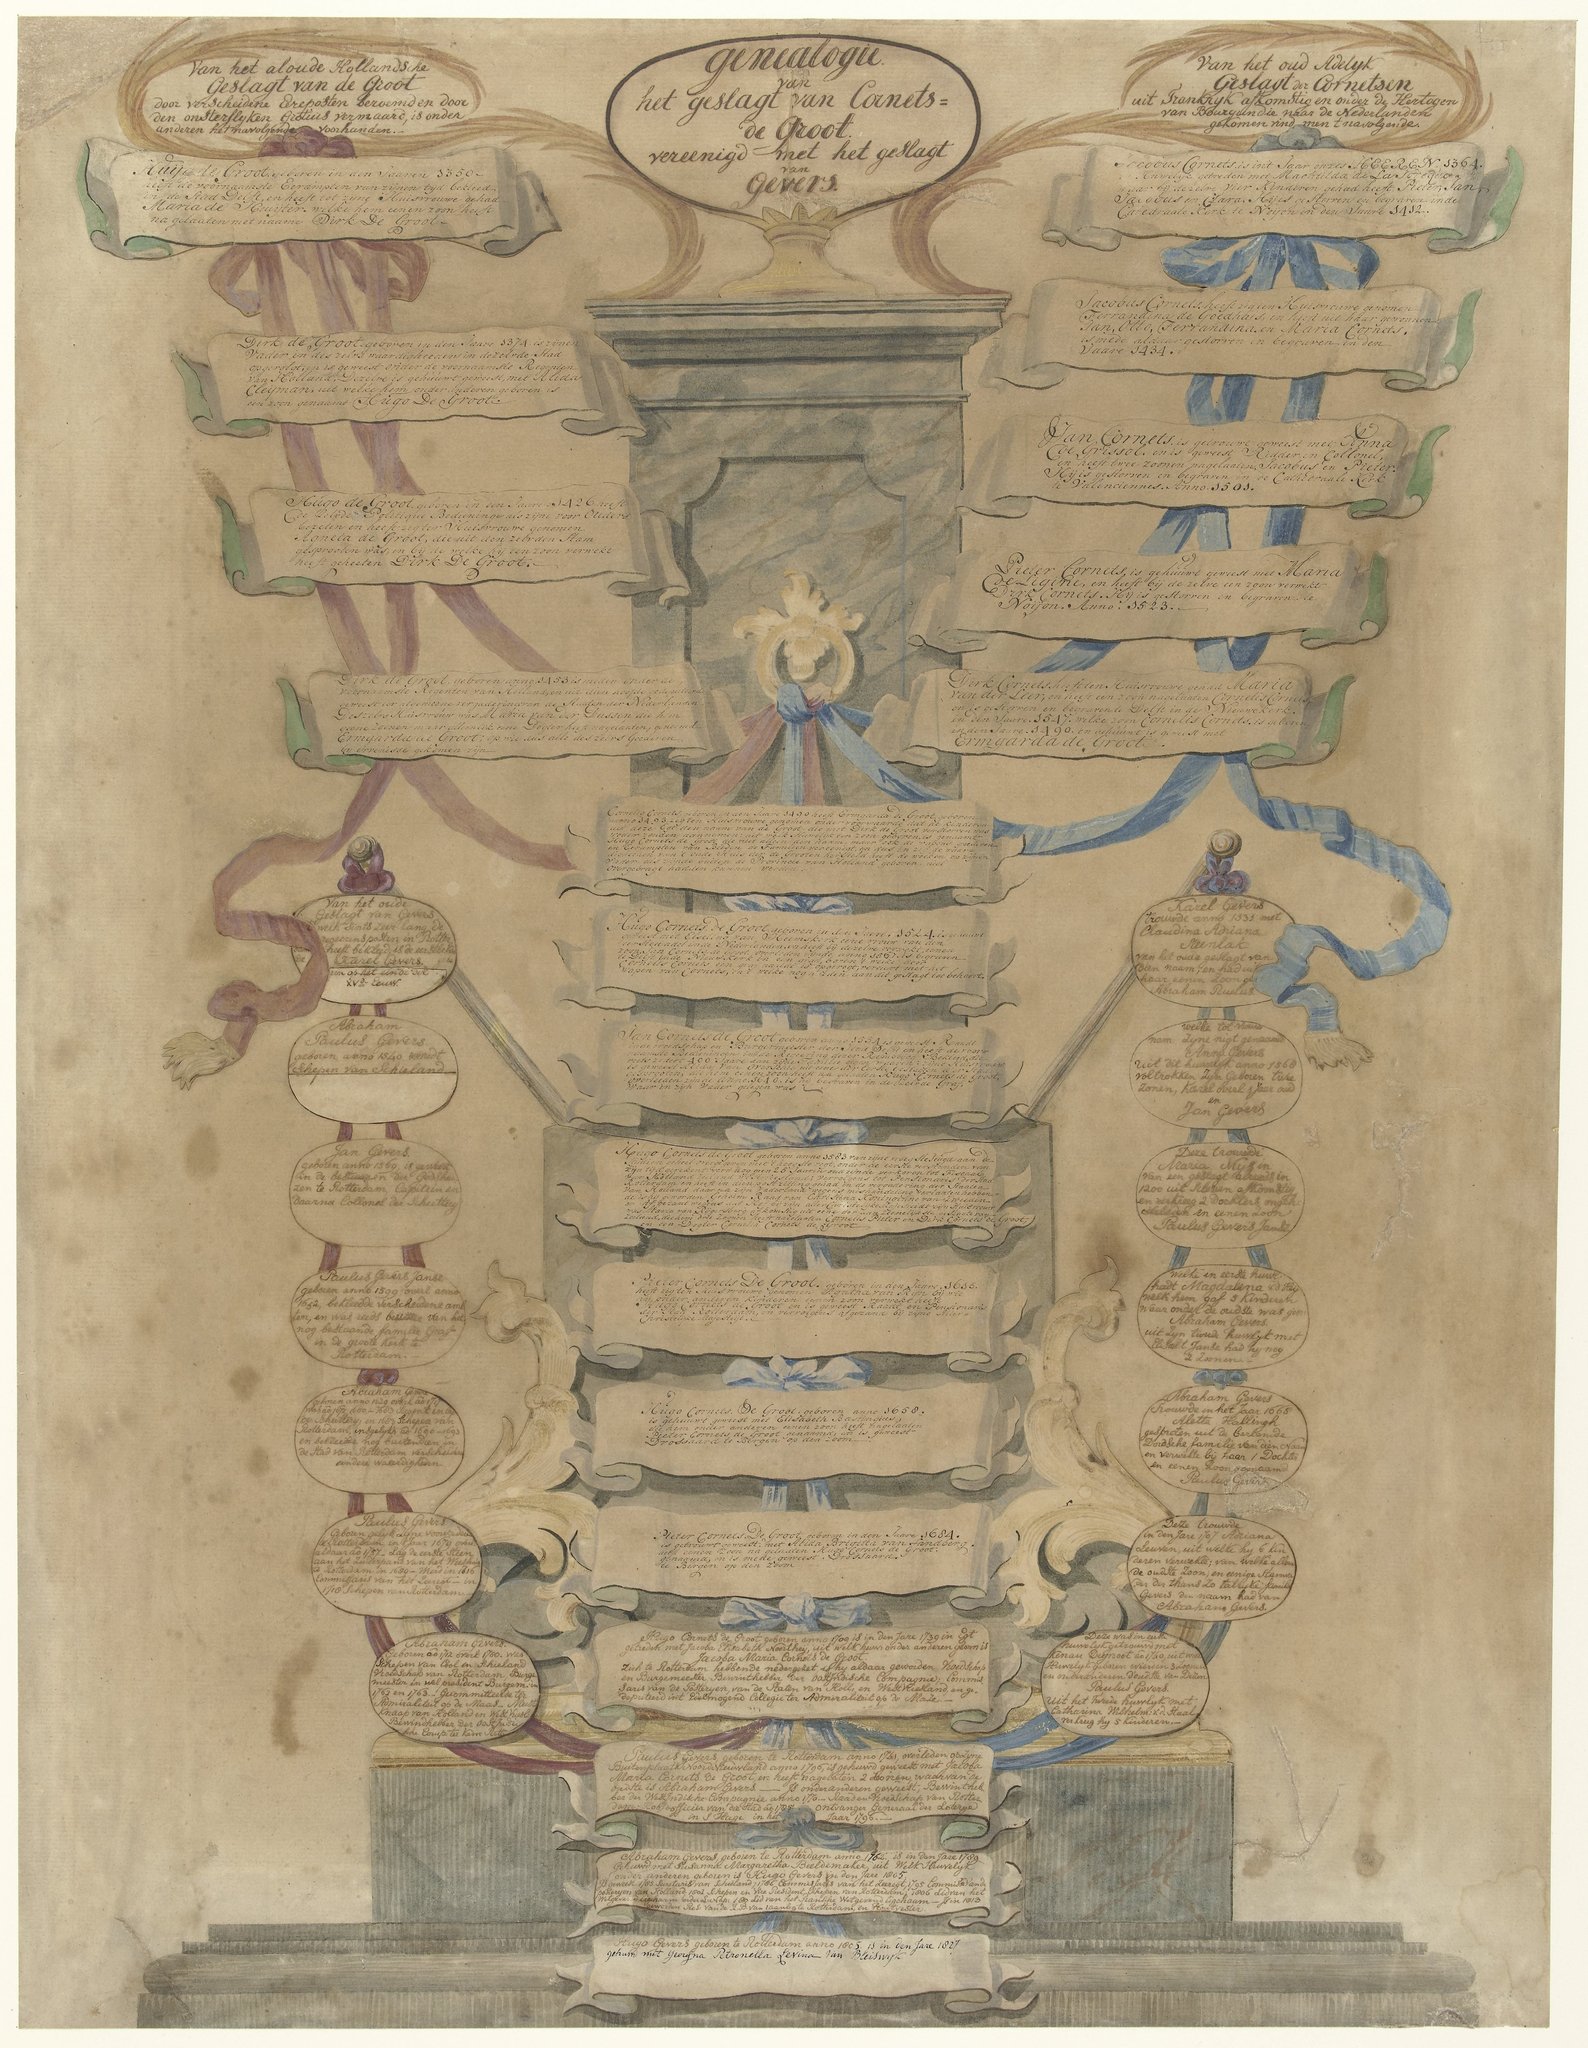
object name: drawing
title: Stamboom van het geslacht van Cornets-de Groot, verenigd met het geslacht van Gevers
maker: Anonymous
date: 1700-1800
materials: ink, paper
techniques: brush, pen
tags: family lineage, pedigree, genealogical tree or table